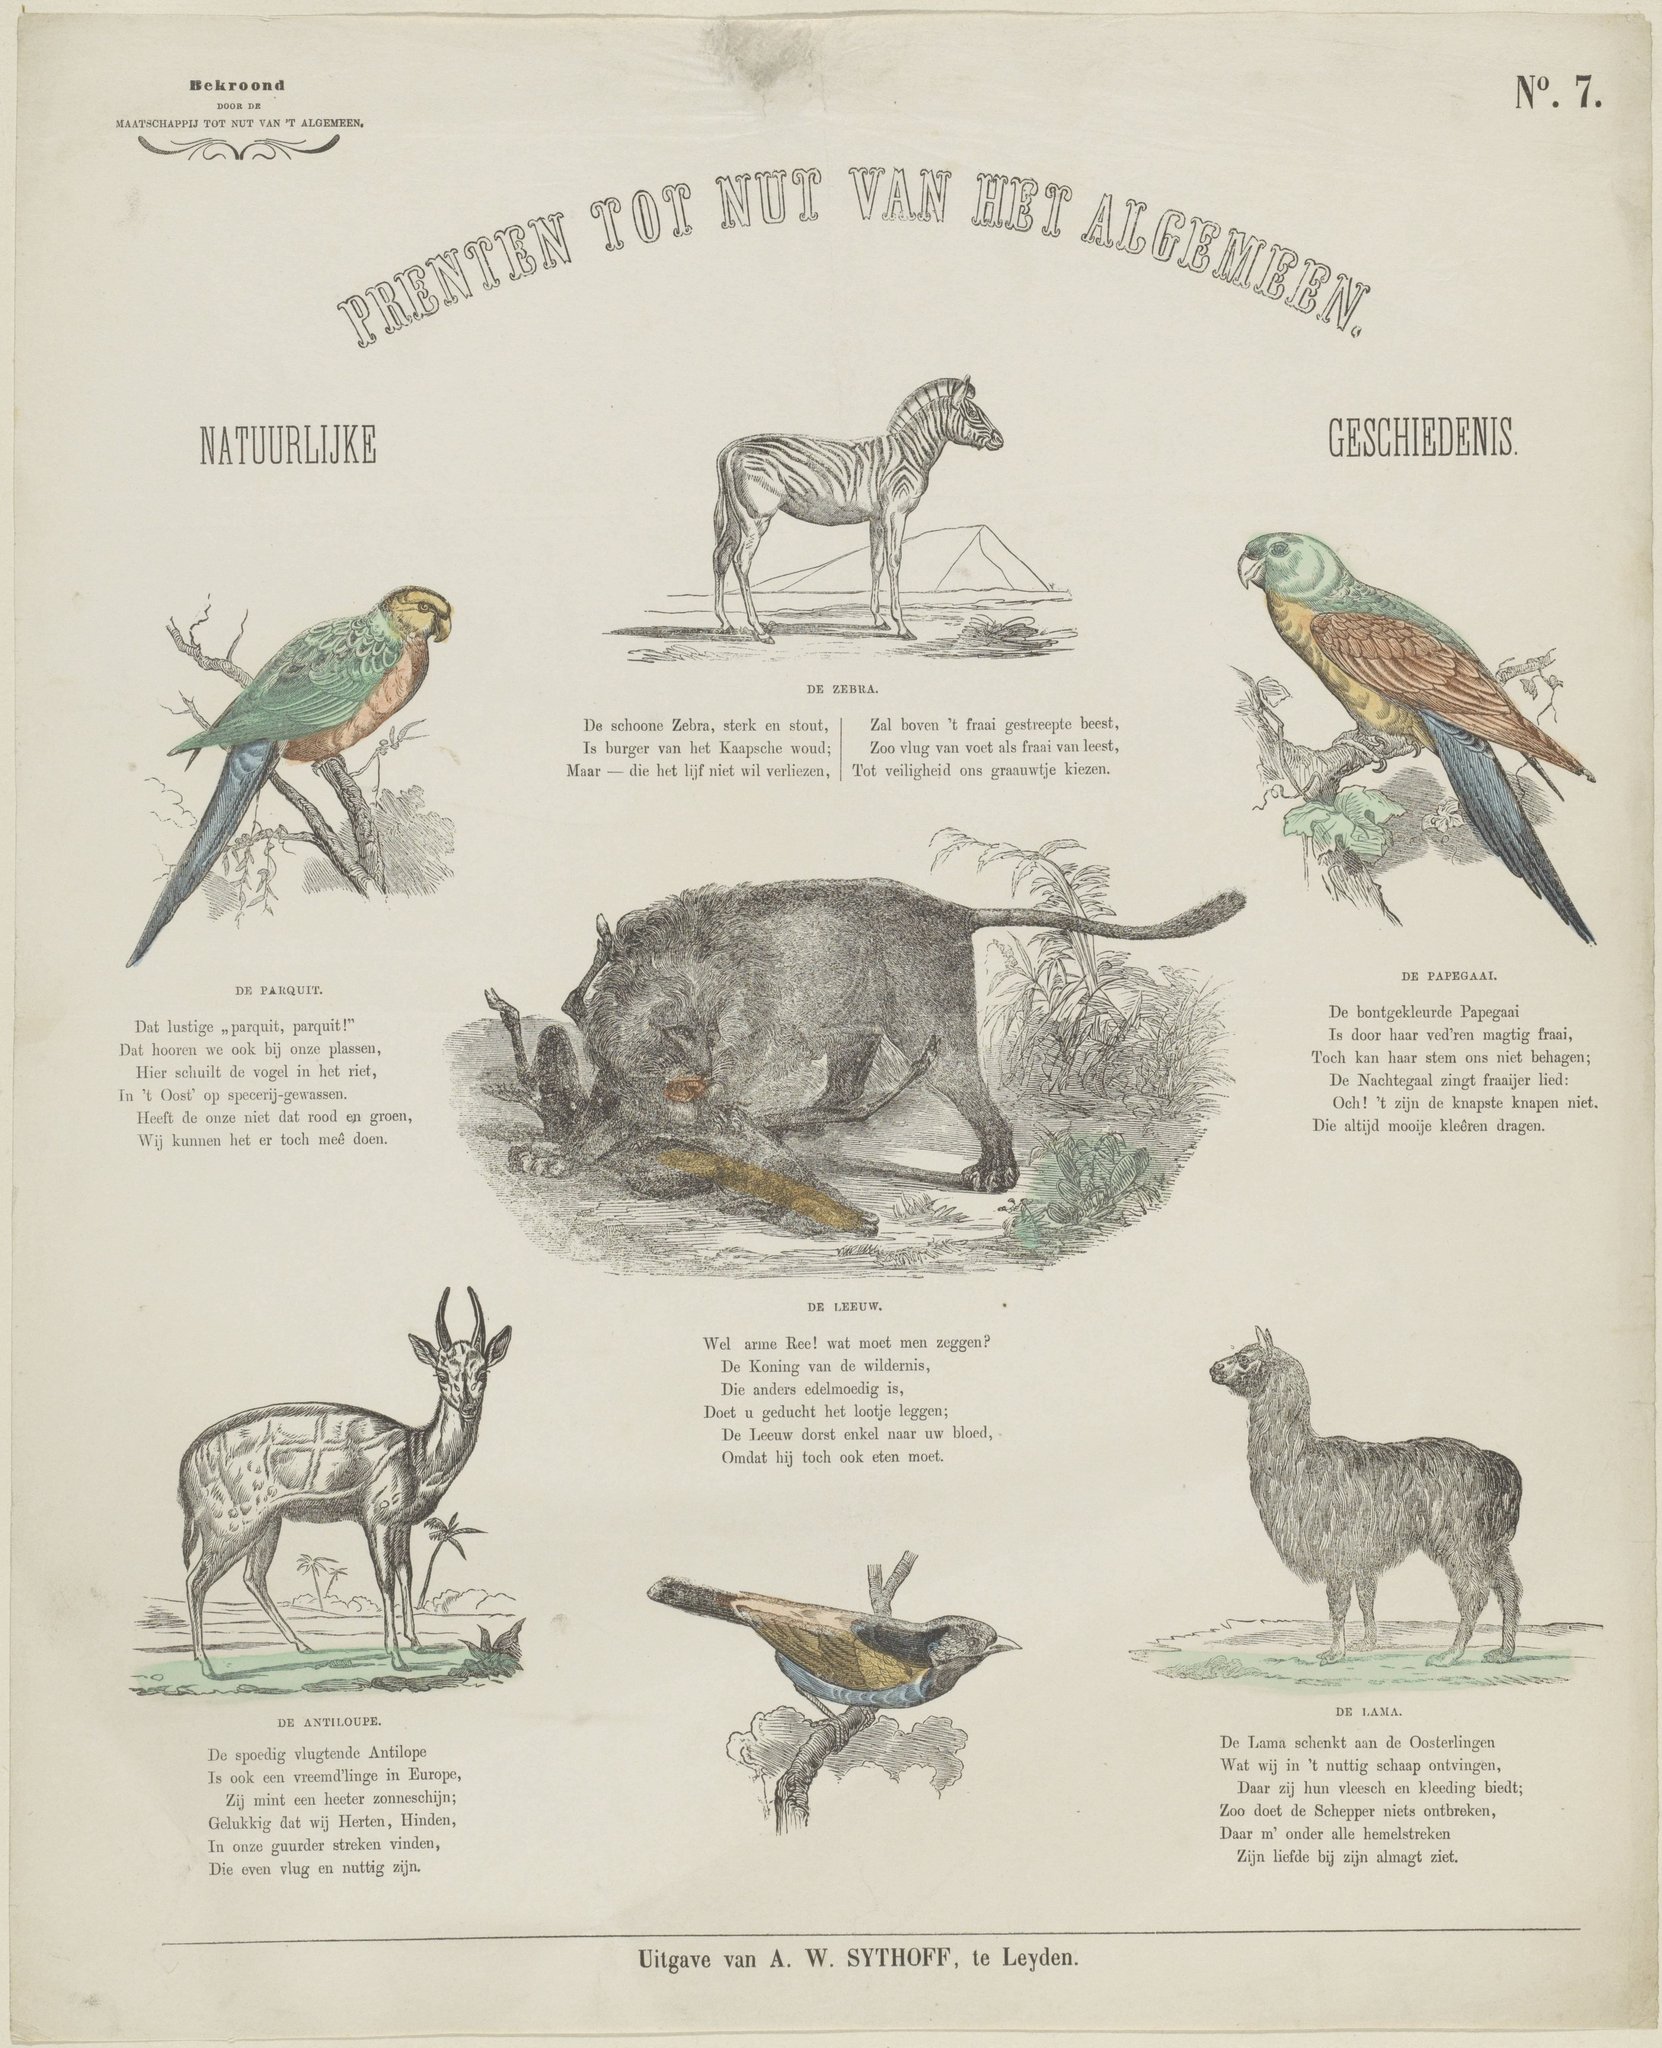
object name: print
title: Prenten tot nut van het algemeen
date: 1861-1929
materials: paper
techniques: colour, letterpress printing, engraving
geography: leiden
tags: animals, birds, ornamental birds: parrot, beasts of prey, predatory animals: lion, hoofed animals: antelope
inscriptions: collector's mark: Lugt 2760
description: Blad met 7 voorstellingen van dieren, zoals een parkiet, een zebra en een leeuw. Onder enkele voorstellingen een titel en een vers. Genummerd rechtsboven: No. 7. Linksboven: Bekroond door de Maatschappij tot Nut van 't Algemeen.